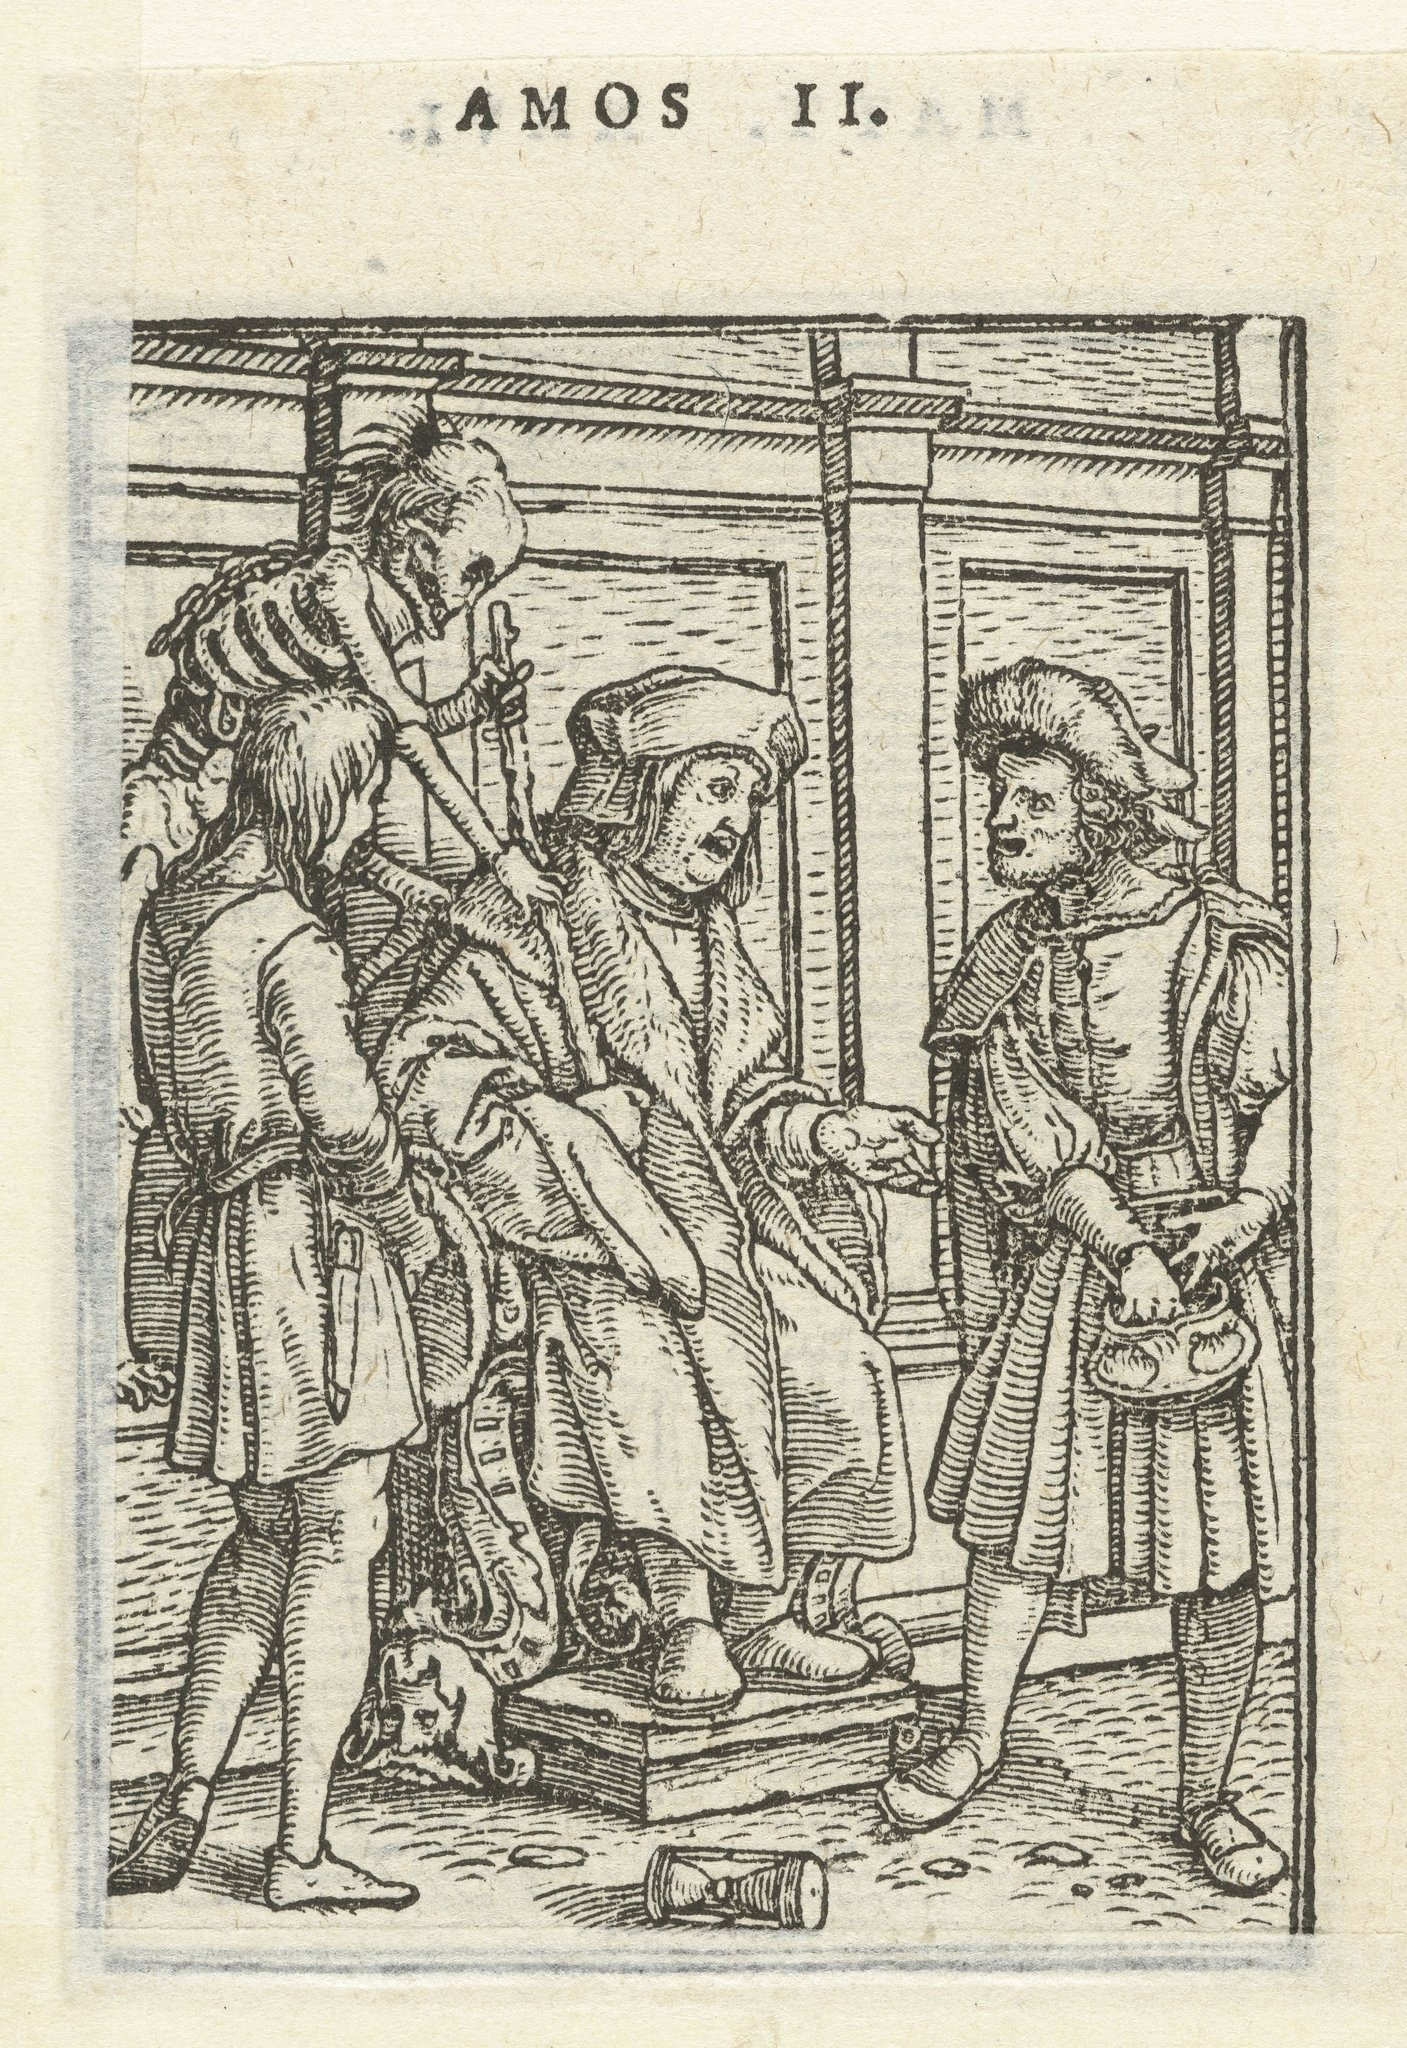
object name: print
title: Rechter en de Dood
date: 1524-1526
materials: paper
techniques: woodcut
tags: dance of death; death together with one or more human beings, magistracy, judges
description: De houtblokken werden voor 1526 vervaardigd door Hans Lützelburg en pas in 1538 voor het eerst gebruikt als boekillustraties in: Les simulachres & historiees faces de la mort avtant elegamment pourtraictes que artificiellement imaginées... a Lyon, Soubsz l'escu de Coloigne, MDXXXVIII, (M. en G. Trechsel, voor F. Frellon in Lyon), 1538. Later verschenen nog andere uitgaven.